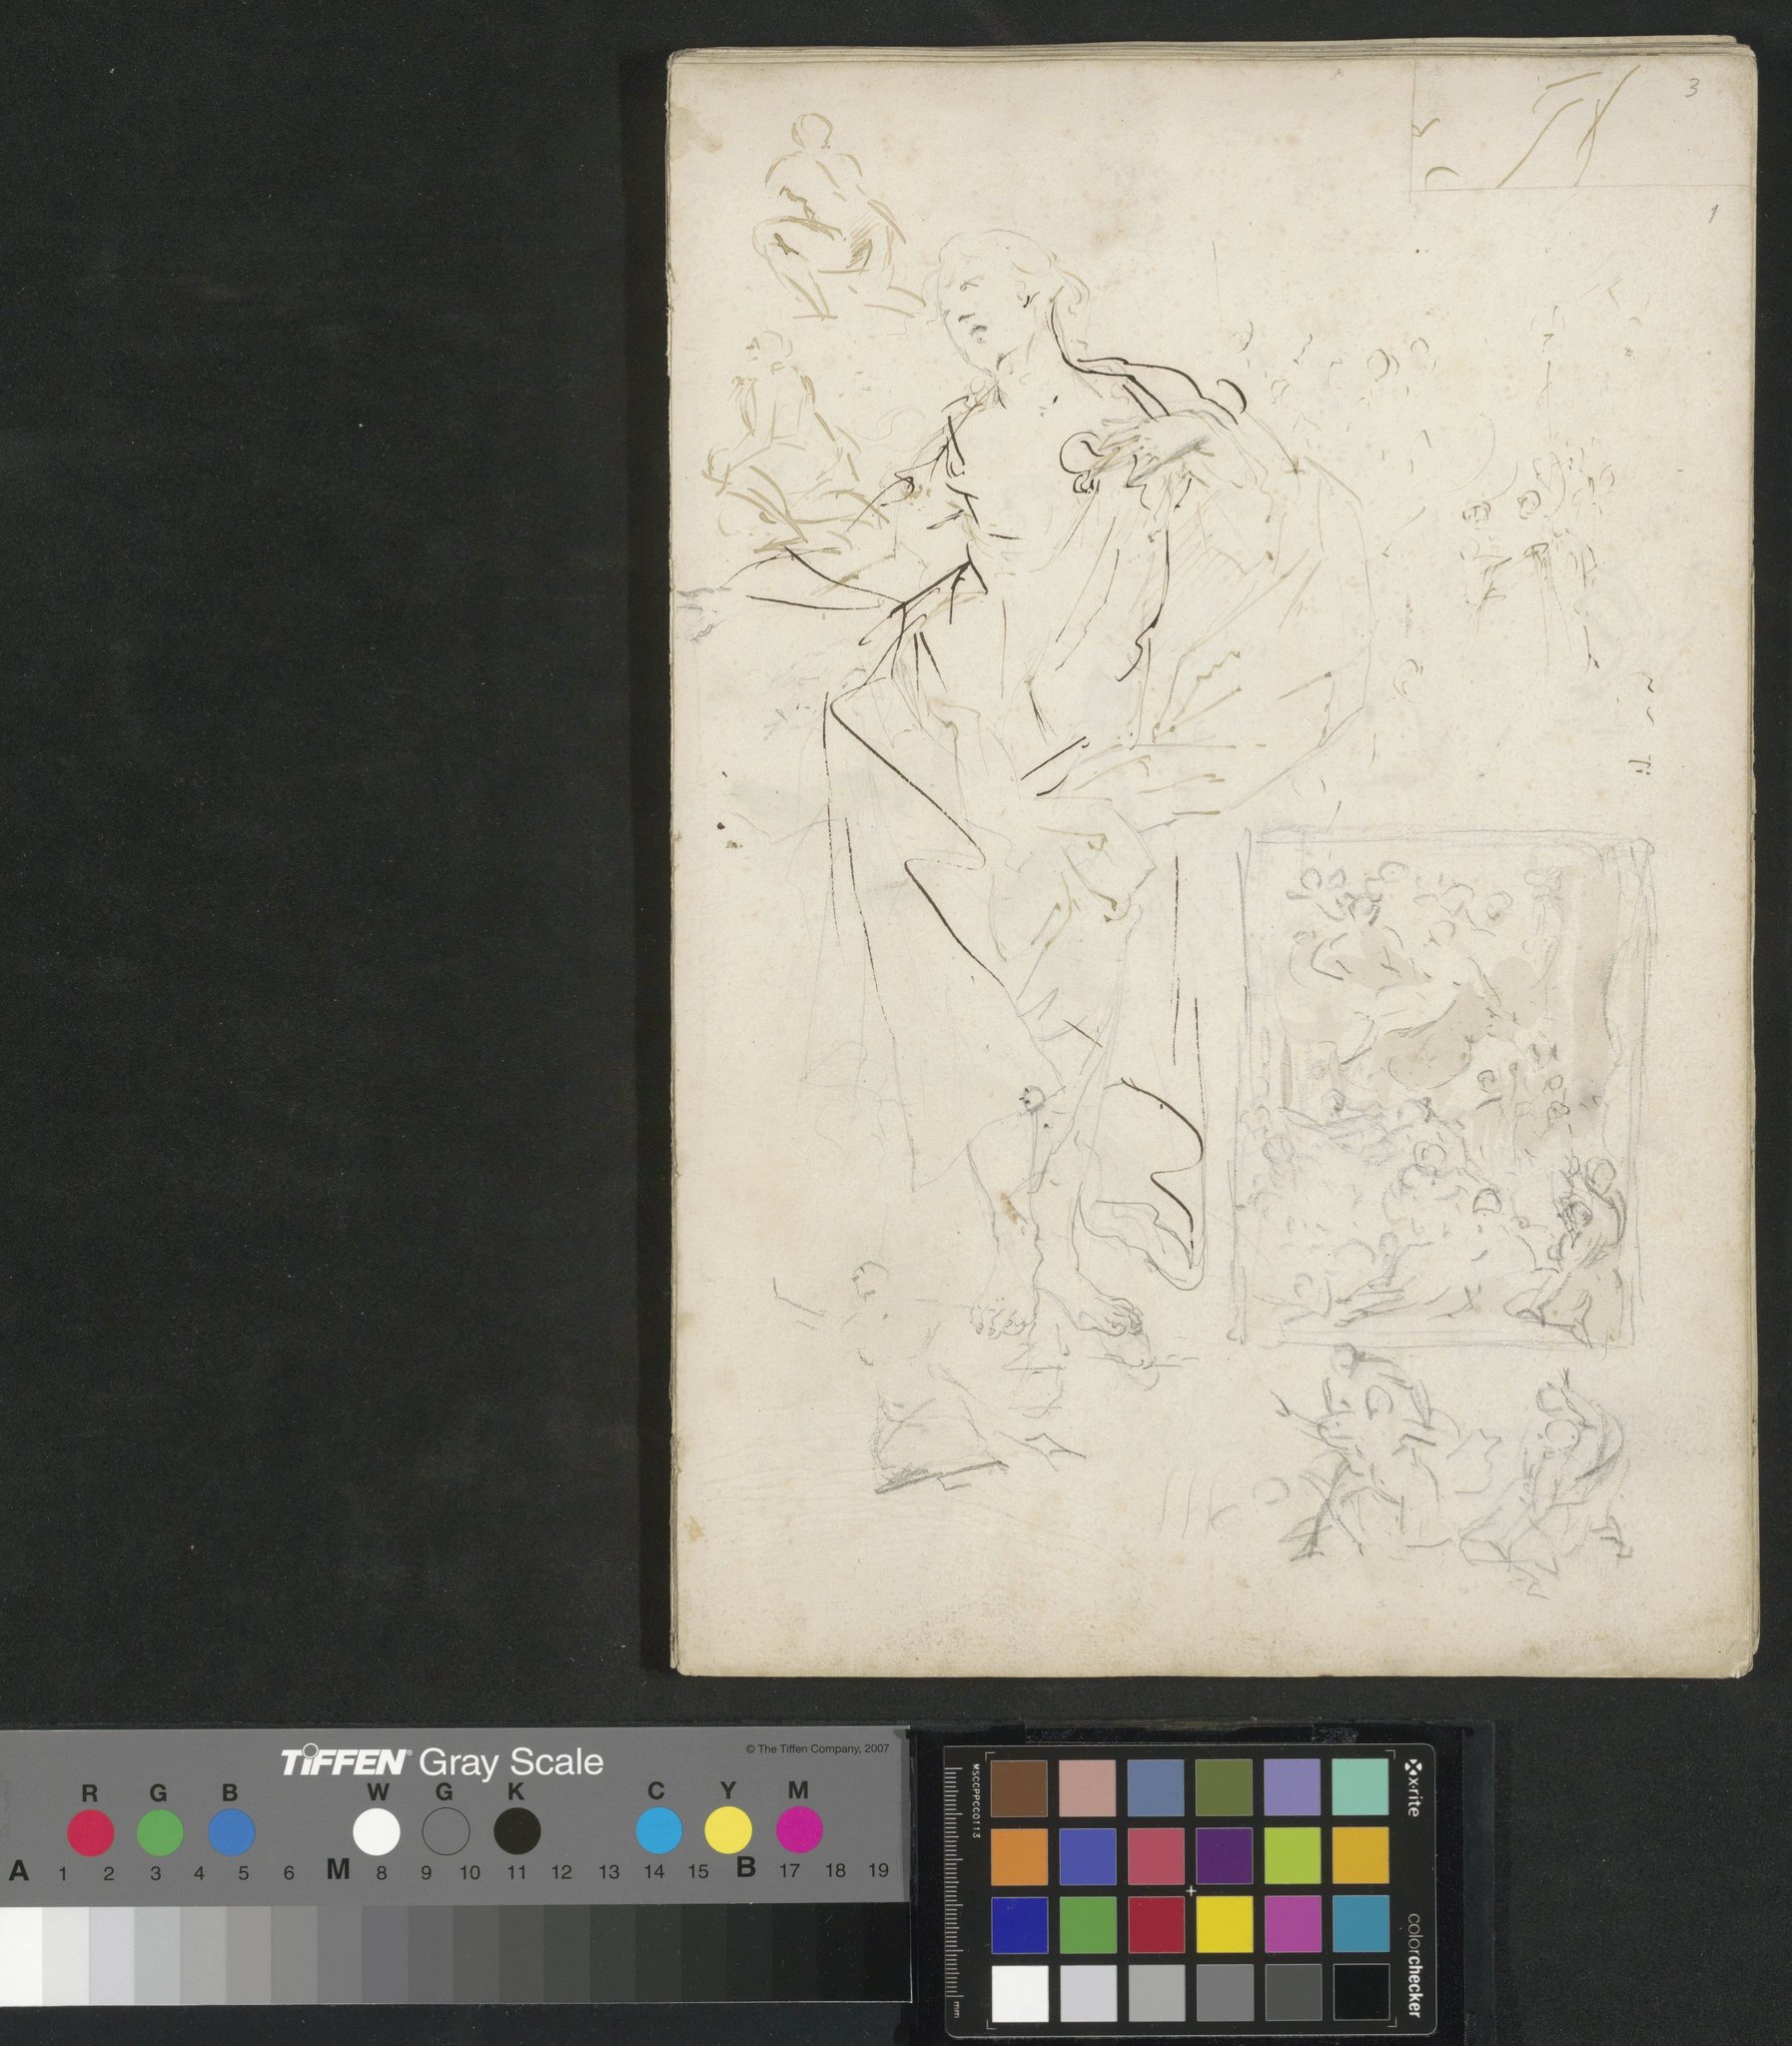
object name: sketchbook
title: Schetsboek met 72 bladzijden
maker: Anonymous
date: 1650-1799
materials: chalk, ink, paper, pencil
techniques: brush, pen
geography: italy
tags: abstract ideas and concepts (+ allegorical scene, i.e. two or more personifications involved in an action), anatomy (non-medical)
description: Losbladig schetsboek bestaande uit 72 bladzijden met figuurstudies en compositieschetsen, onder andere van bijbelse, mythologische en allegorische voorstellingen. In het boek is door meerdere handen getekend en het bevat notities in het Italiaans en Nederlands.